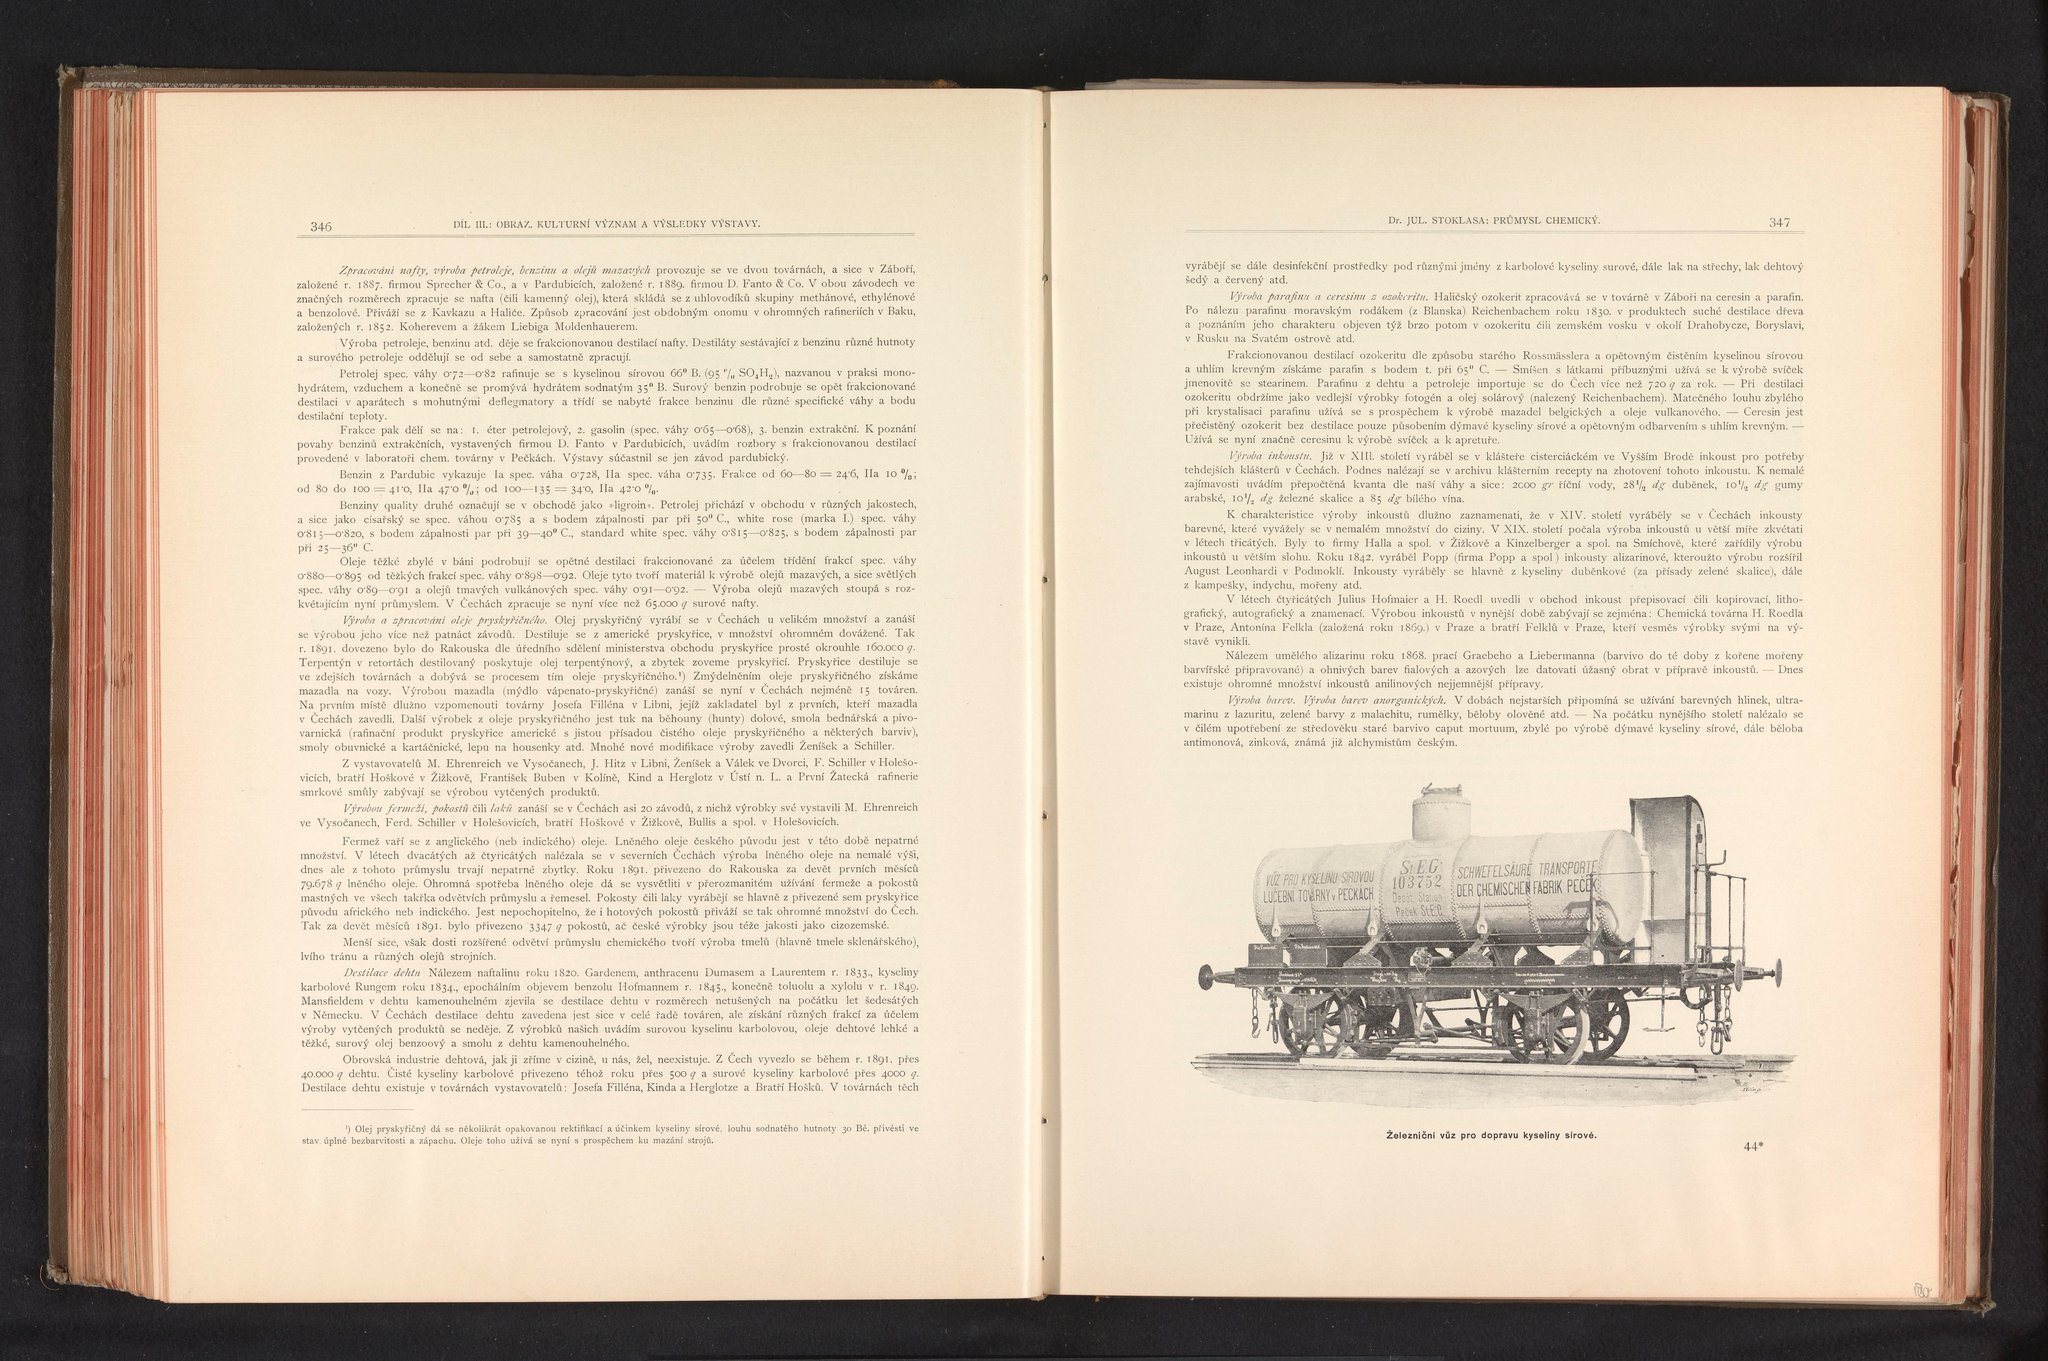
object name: photomechanical print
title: Zeleznicni vuz pro dopravu kyseliny sirové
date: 1890-1895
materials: paper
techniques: autotype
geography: prague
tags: railway wagon